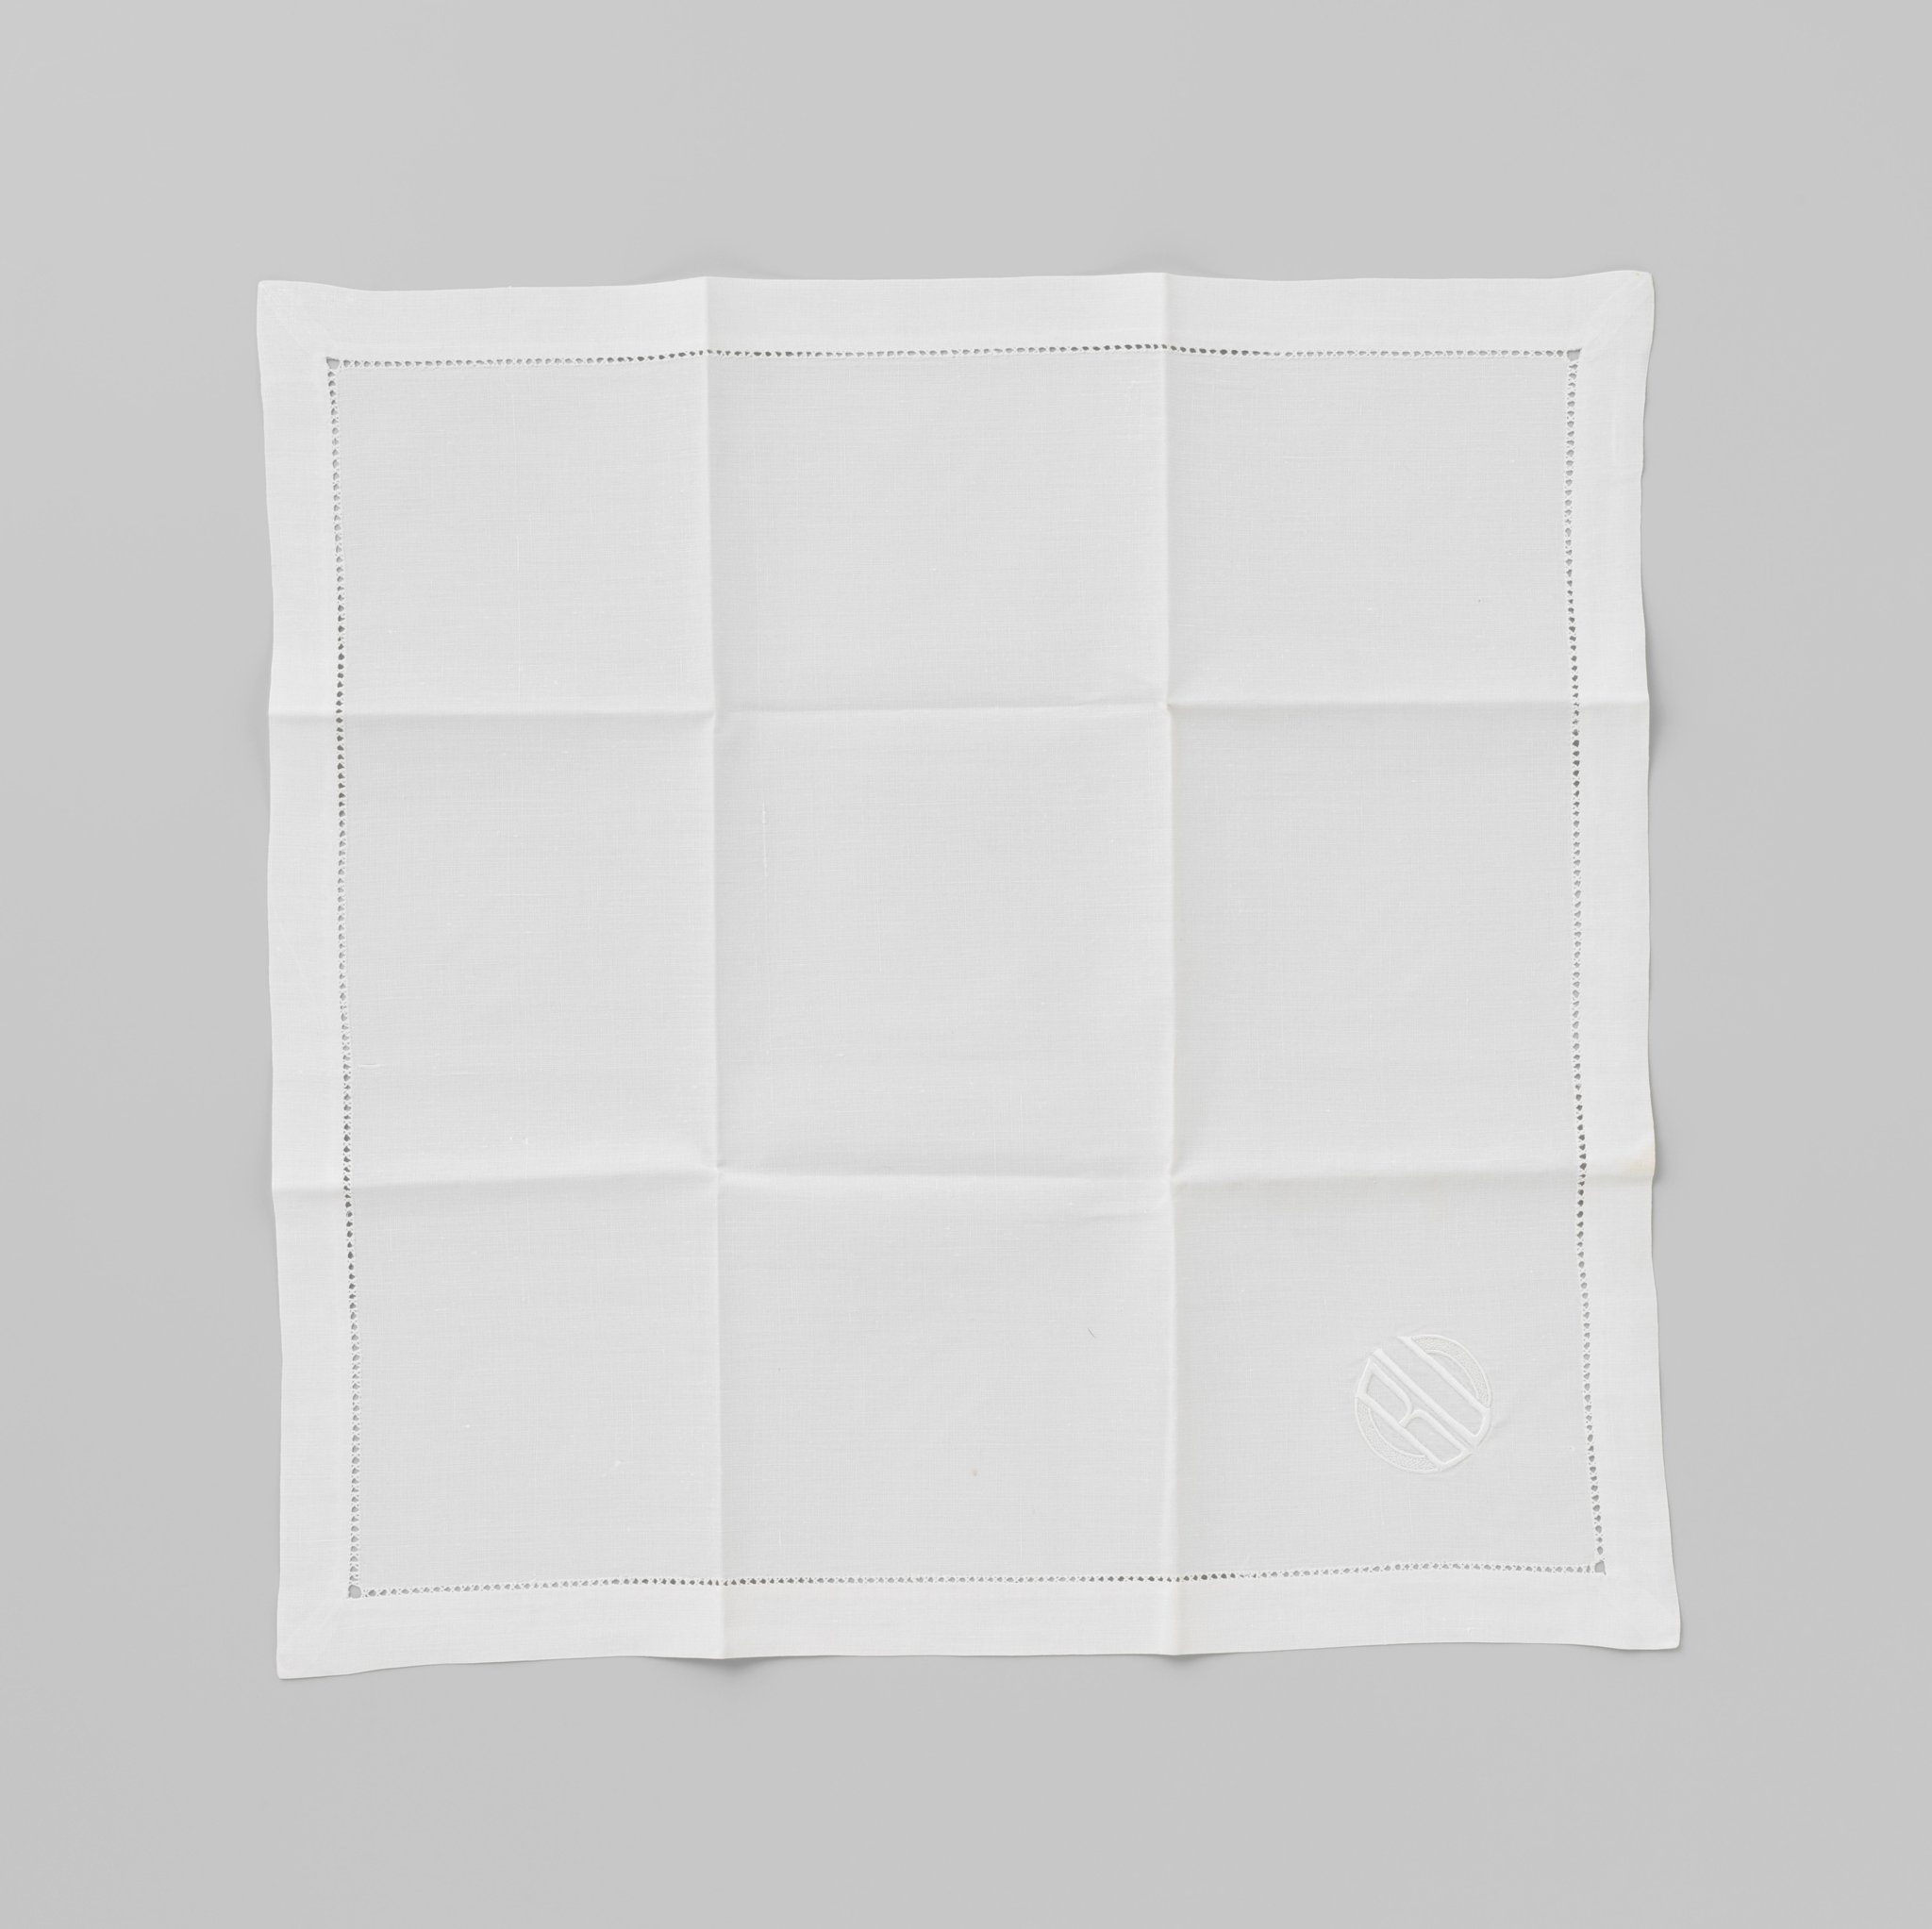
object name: napkin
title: Servet van linnen met de geborduurde initialen BU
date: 1935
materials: linen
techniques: embroidered, weave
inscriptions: initials: ‘BU’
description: Servet van linnen in platbinding, met opengewerkte zomen en de geborduurde initialen BU (Brusse-Urtebise).